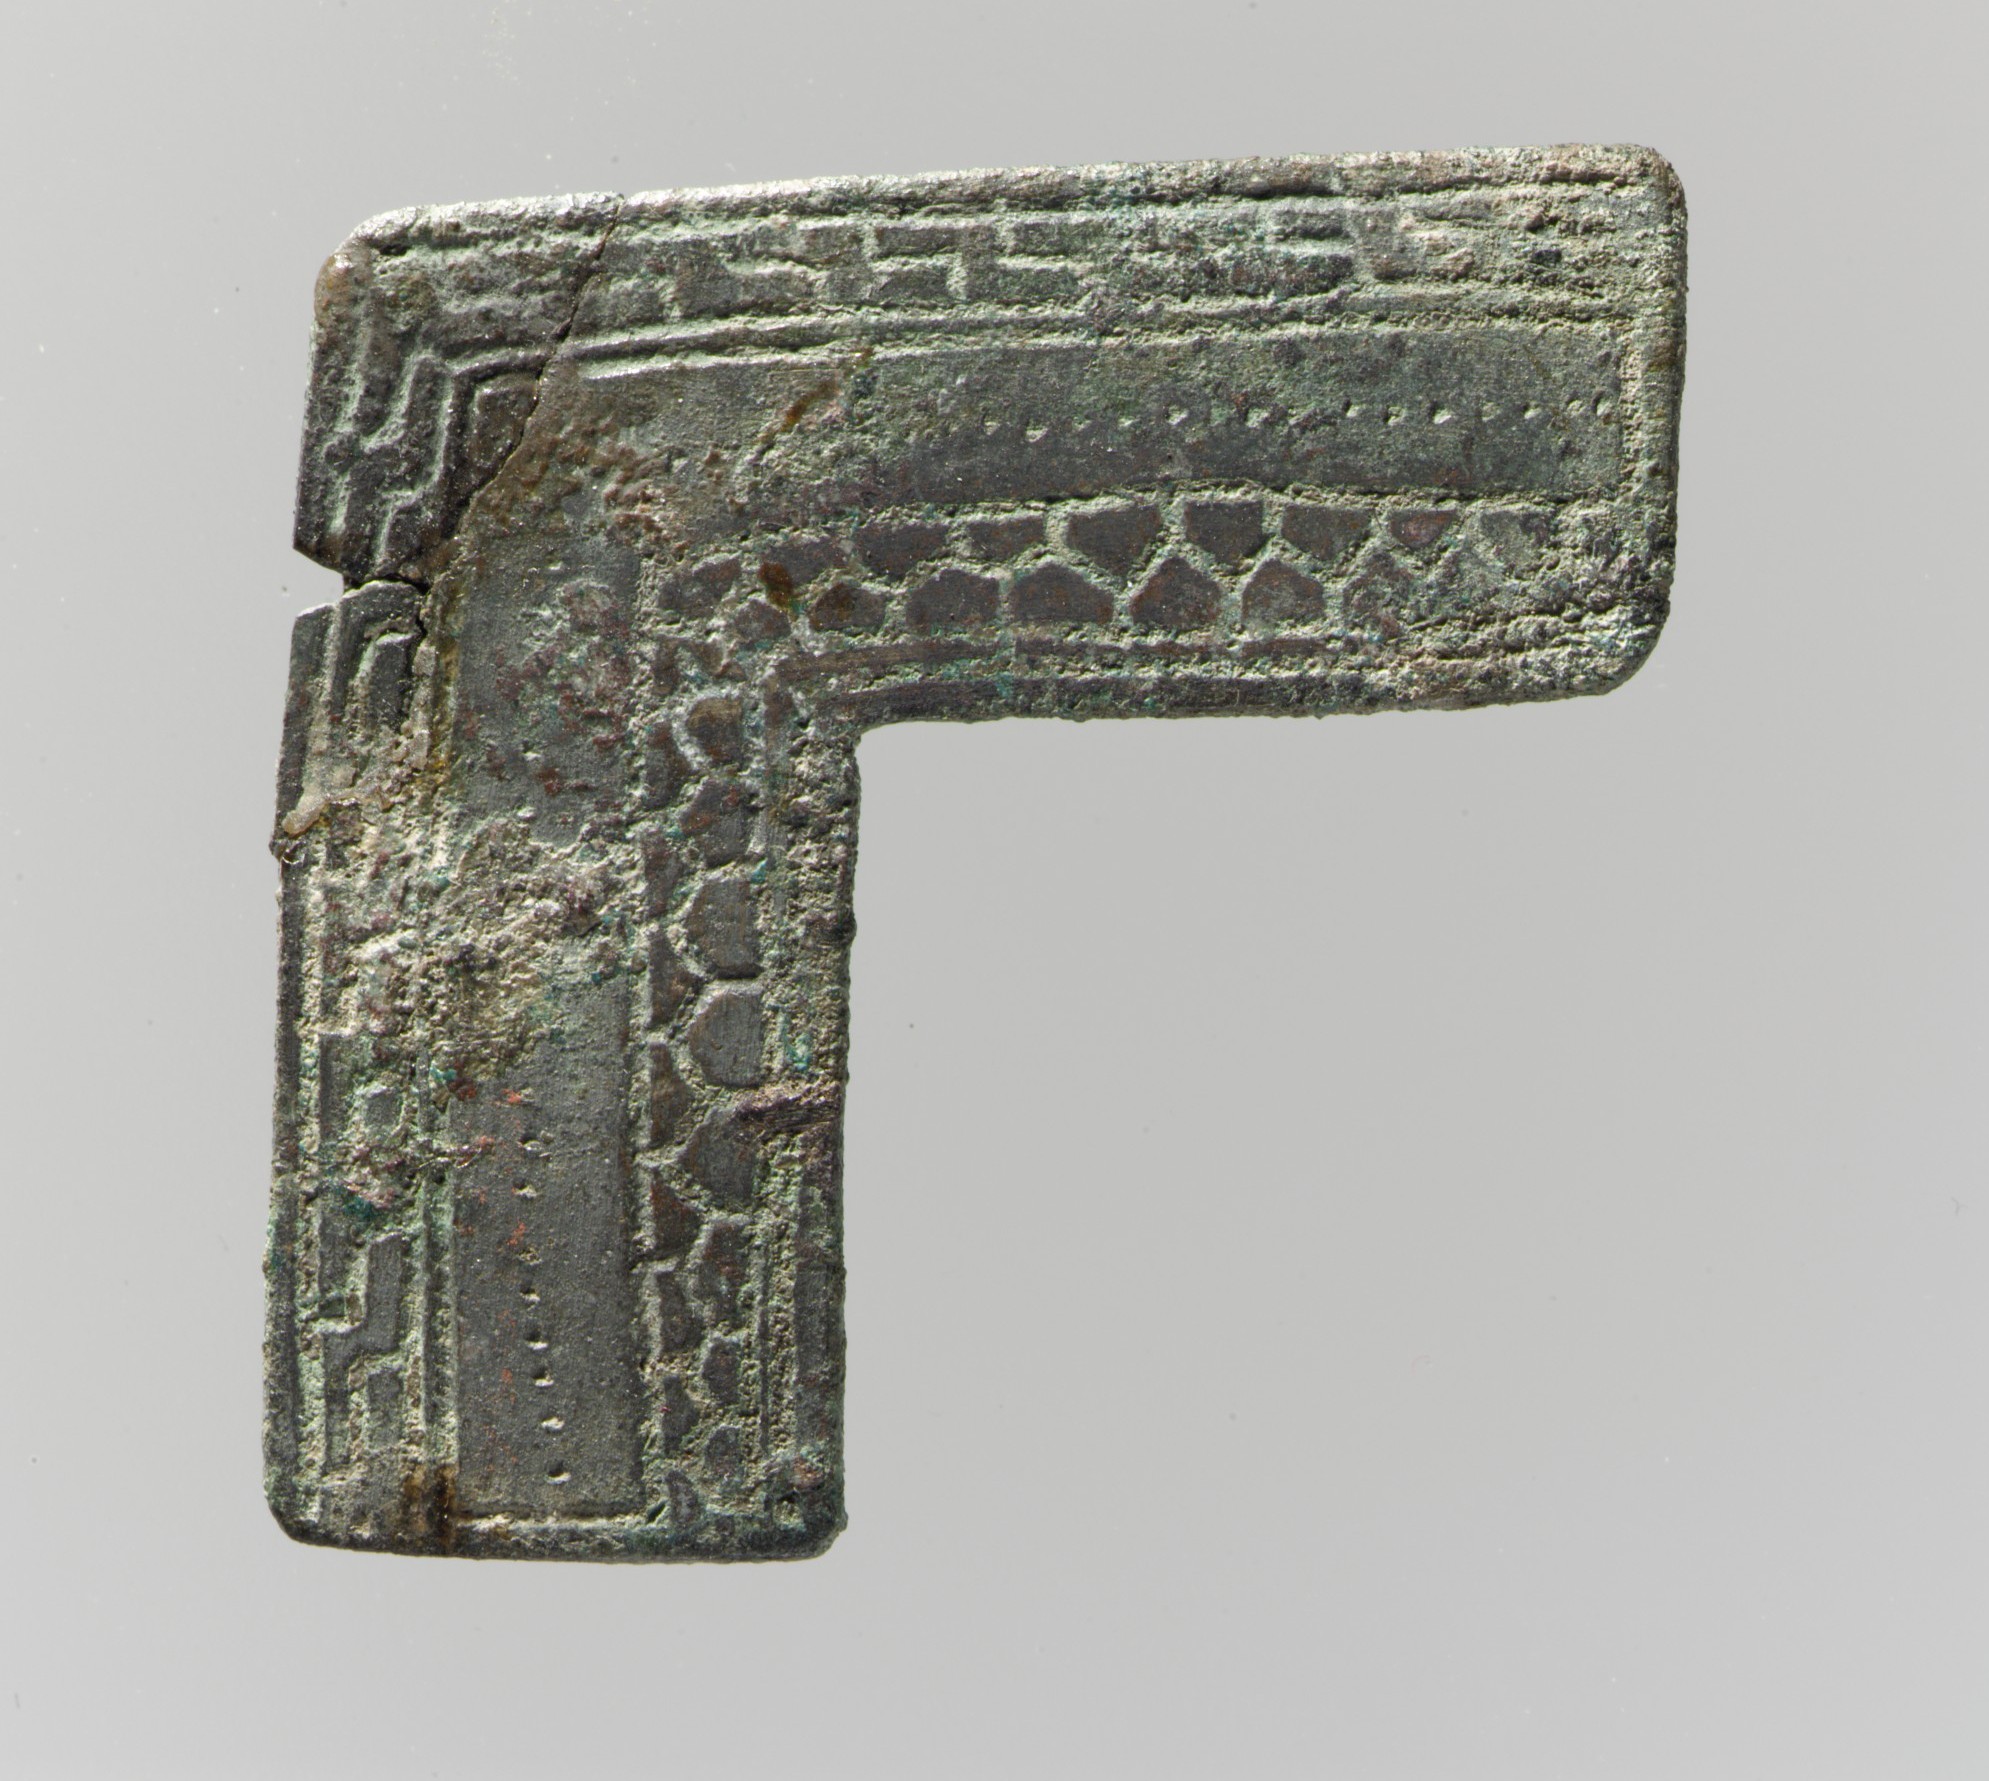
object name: ornament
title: Flat Ornament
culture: frankish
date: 601-700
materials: copper alloy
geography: france